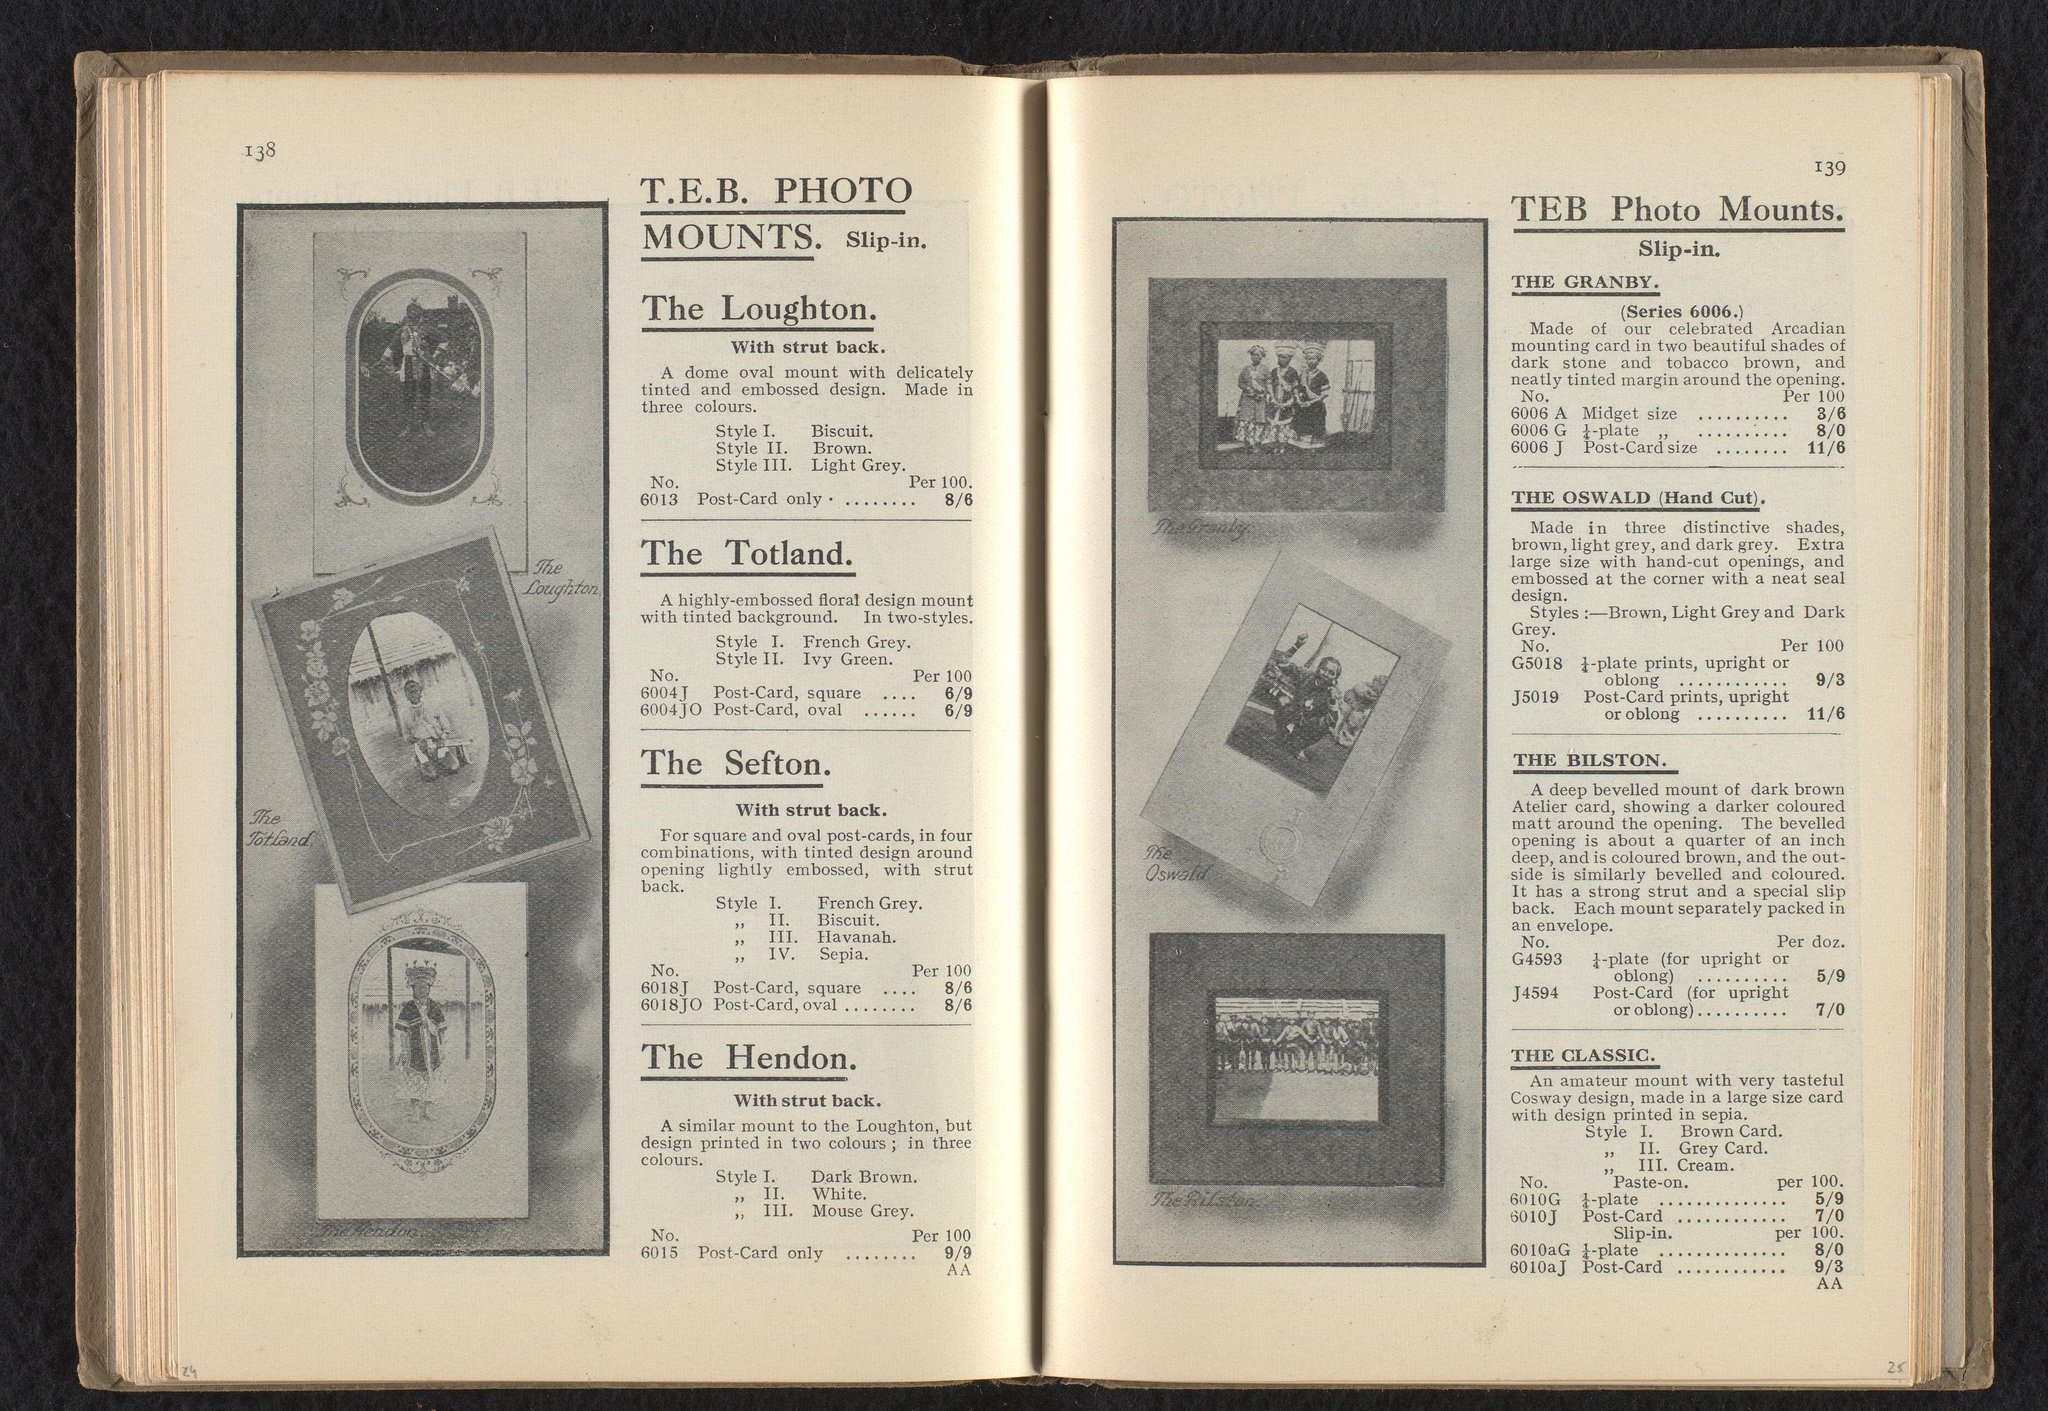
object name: photomechanical print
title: Teb Photo Mounts, The loughton, The Totland, The Hendon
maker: Anonymous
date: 1907-1912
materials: paper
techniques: letterpress printing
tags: photograph, 'passe-partout'